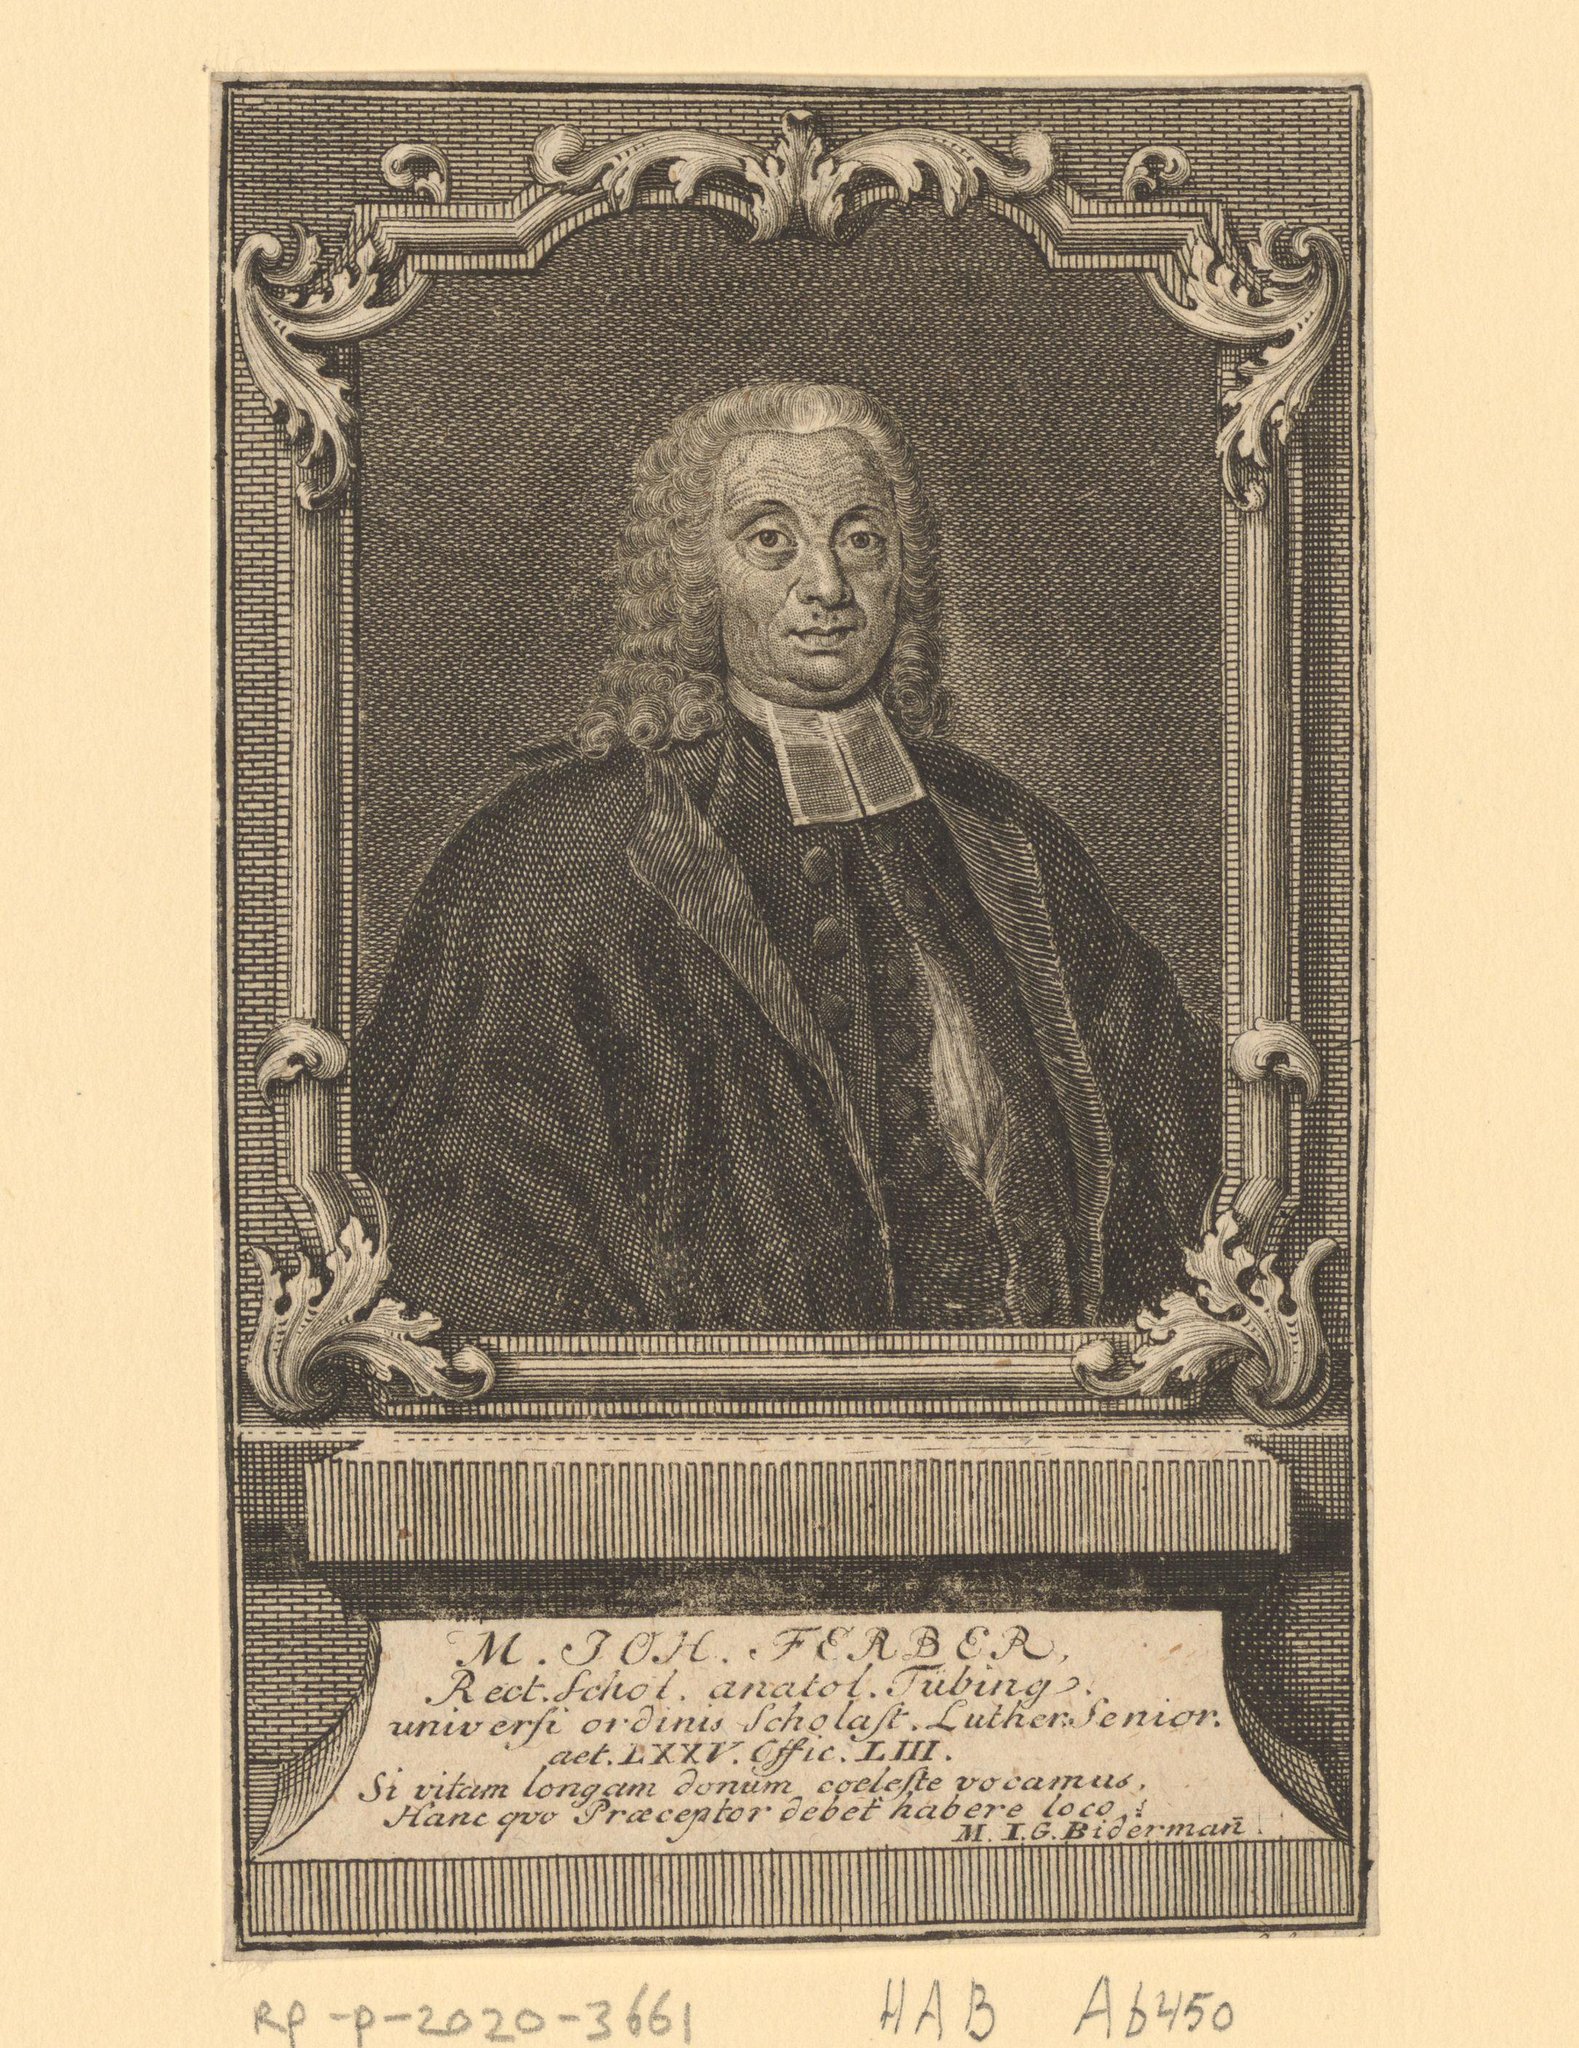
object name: print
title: Portret van Johann Ferber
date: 1749-1757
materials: paper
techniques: etching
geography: leipzig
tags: historical persons